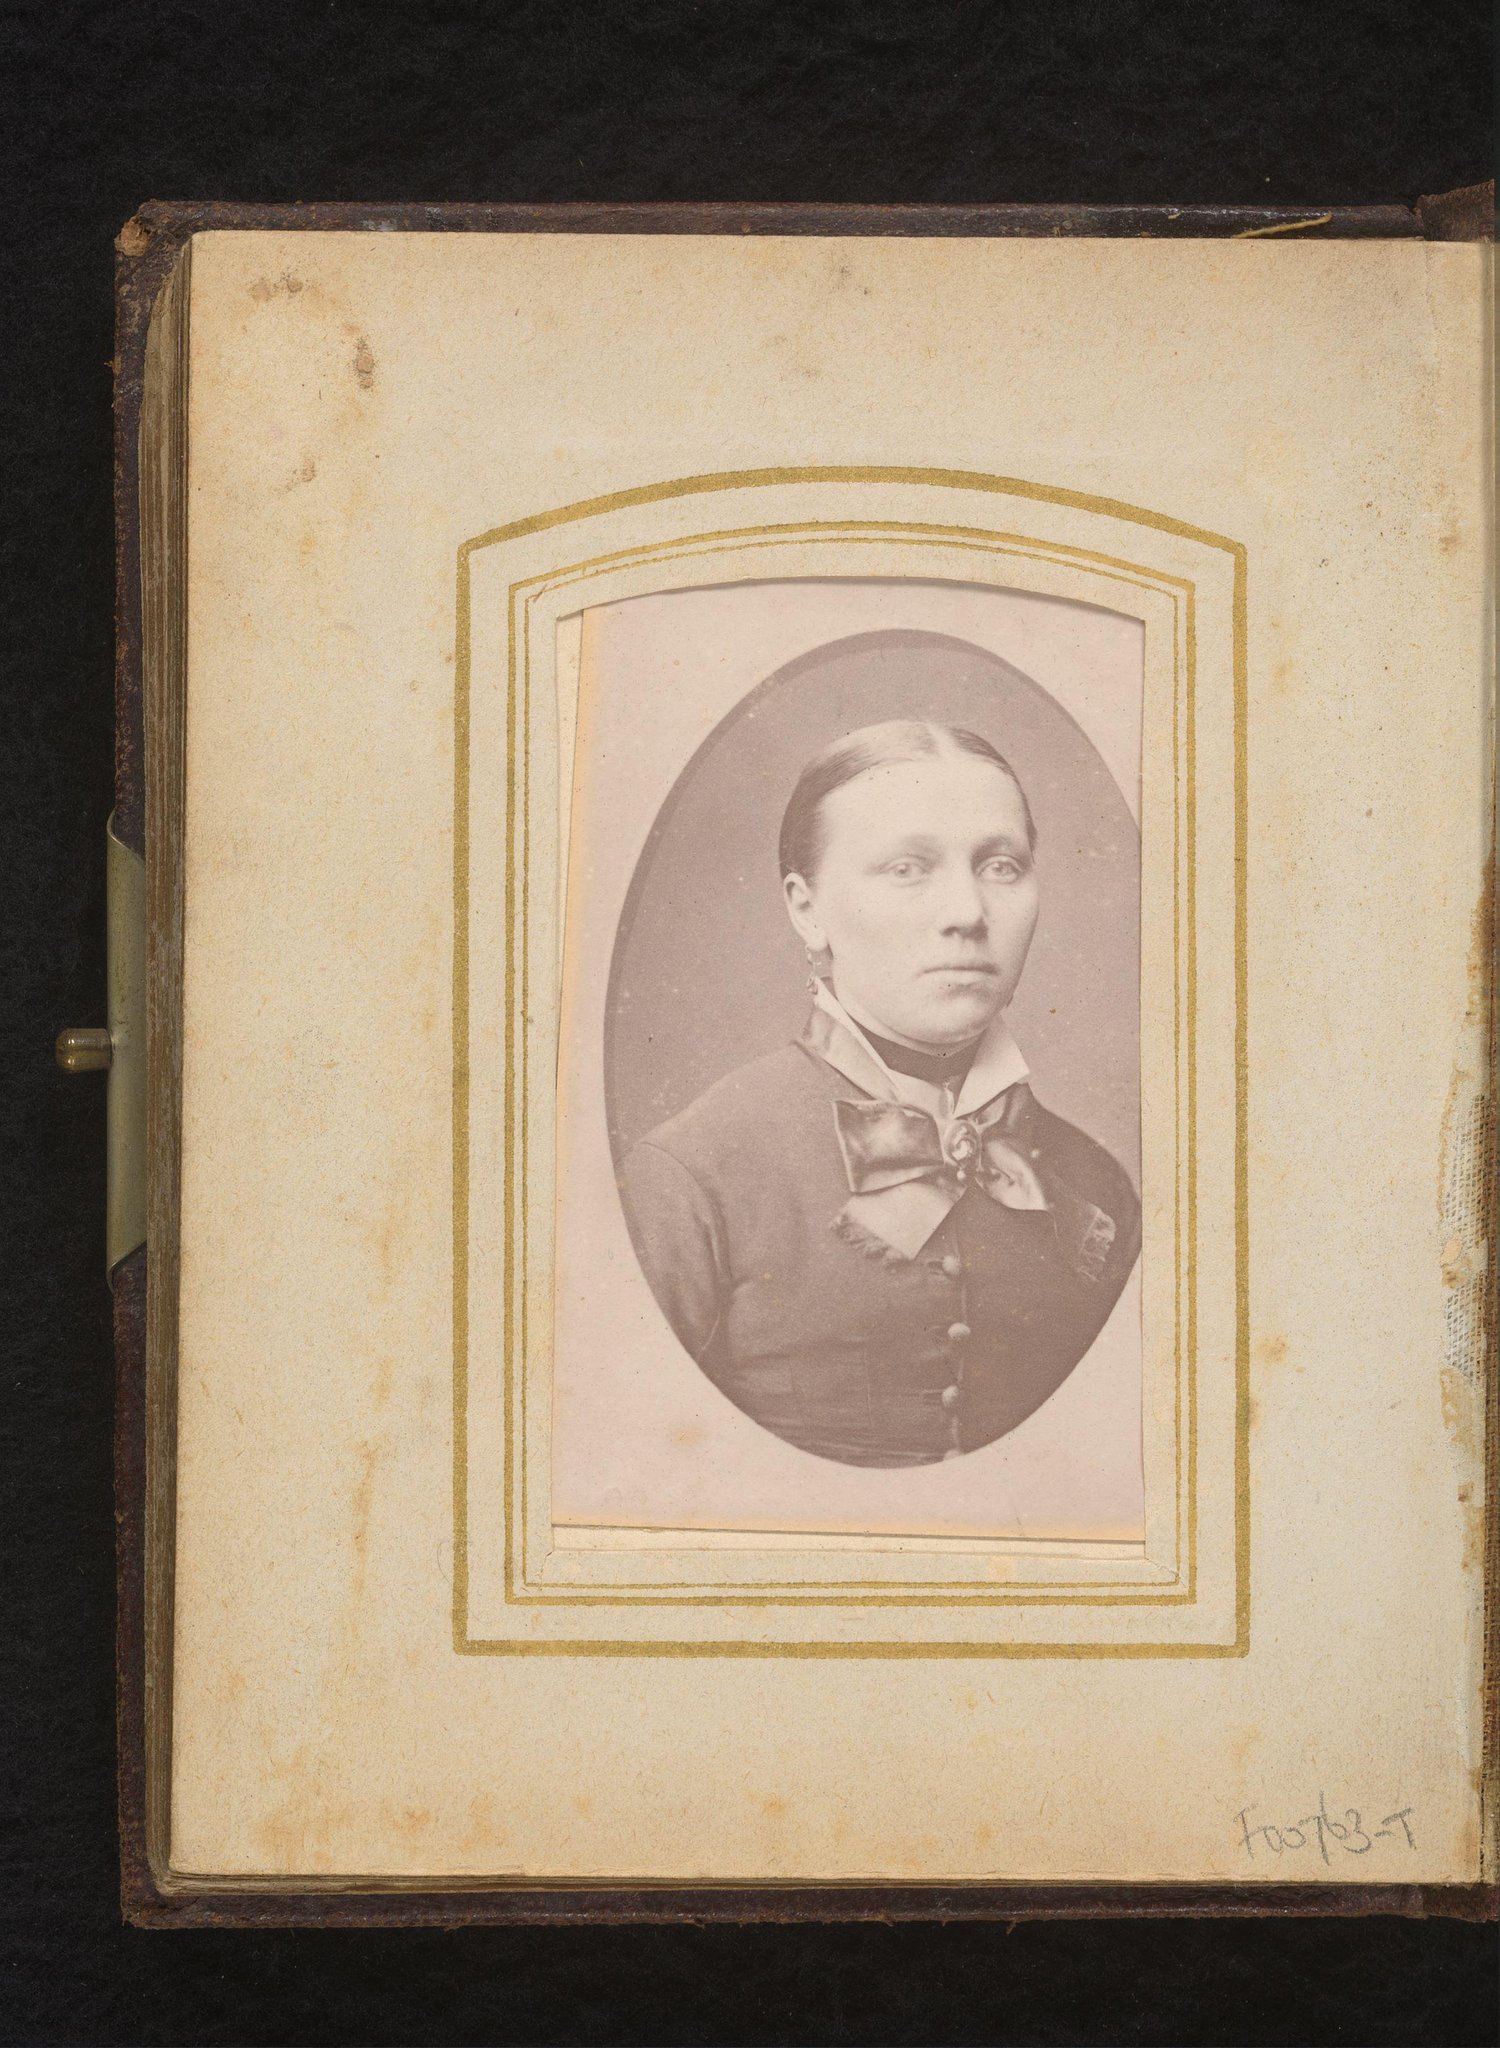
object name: carte de visite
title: Portret van een vrouw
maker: willem gerhardus kuijer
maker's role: fotograaf, hoffotograaf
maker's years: 1834-1899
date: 1862-1899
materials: cardboard, photographic support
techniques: albumen print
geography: amsterdam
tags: historical persons - bb - woman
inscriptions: inscription: ‘W. G. KUIJER/ Photograaph/ Amsterdam/ Rozengracht 72.’